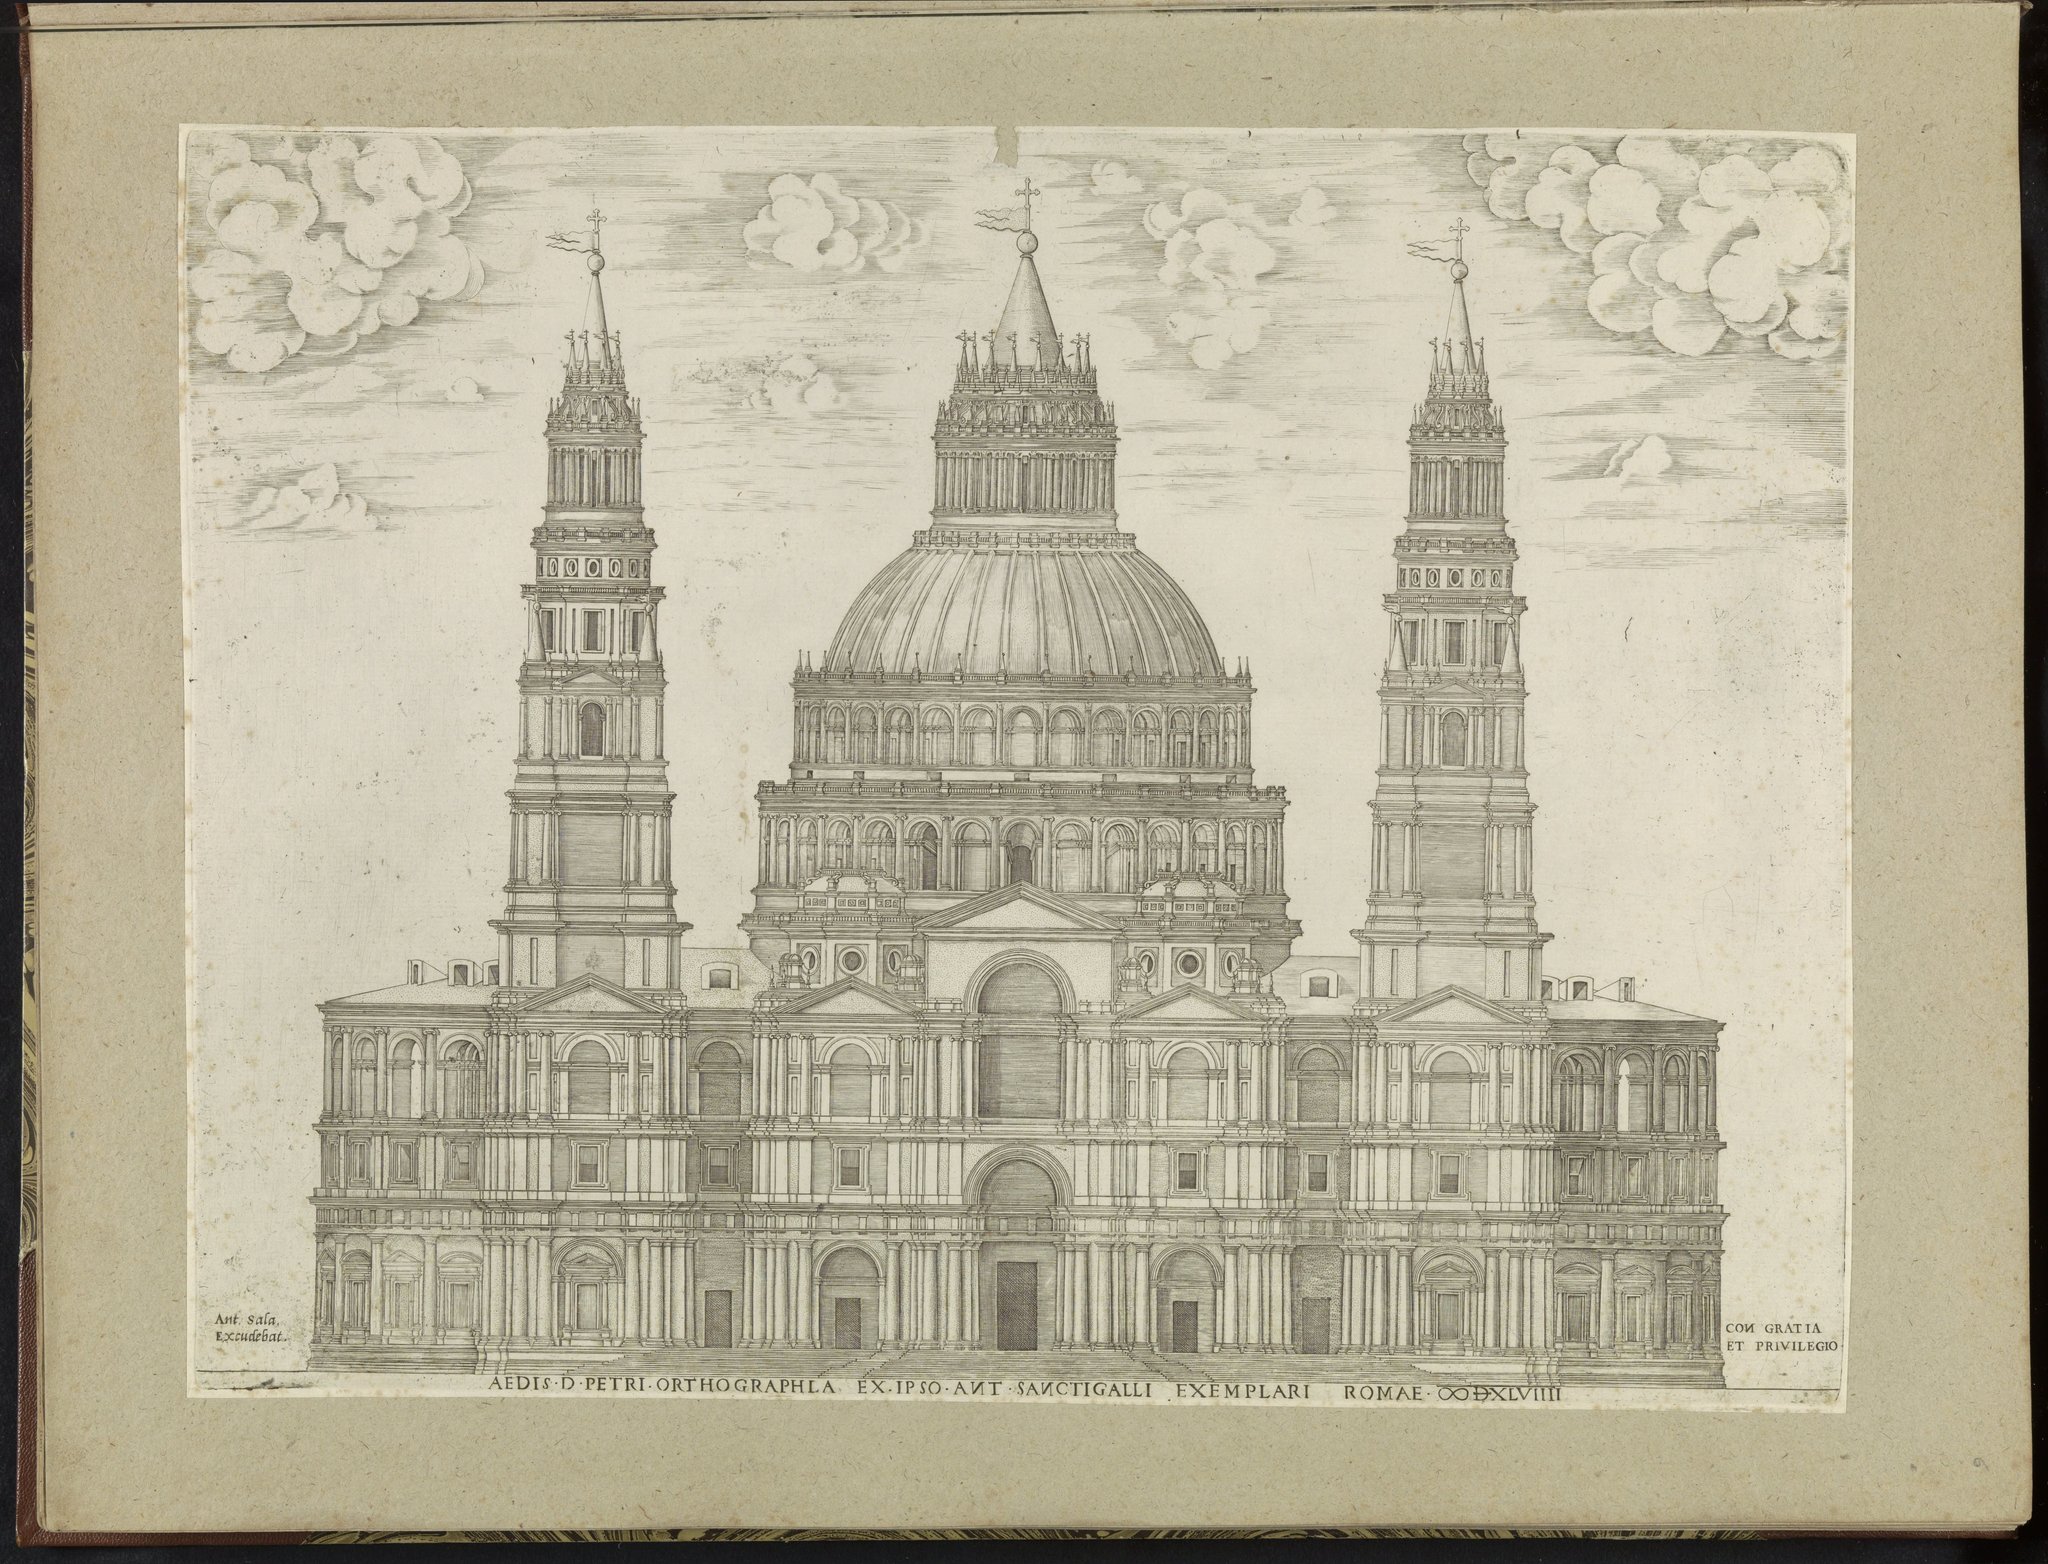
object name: album leaf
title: Ontwerp voor de Sint-Pietersbasiliek te Vaticaanstad door Antonio da Sangallo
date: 1547-1562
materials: paper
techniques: engraving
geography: rome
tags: church (exterior), roman catholic church, parts of church exterior and annexes: façade